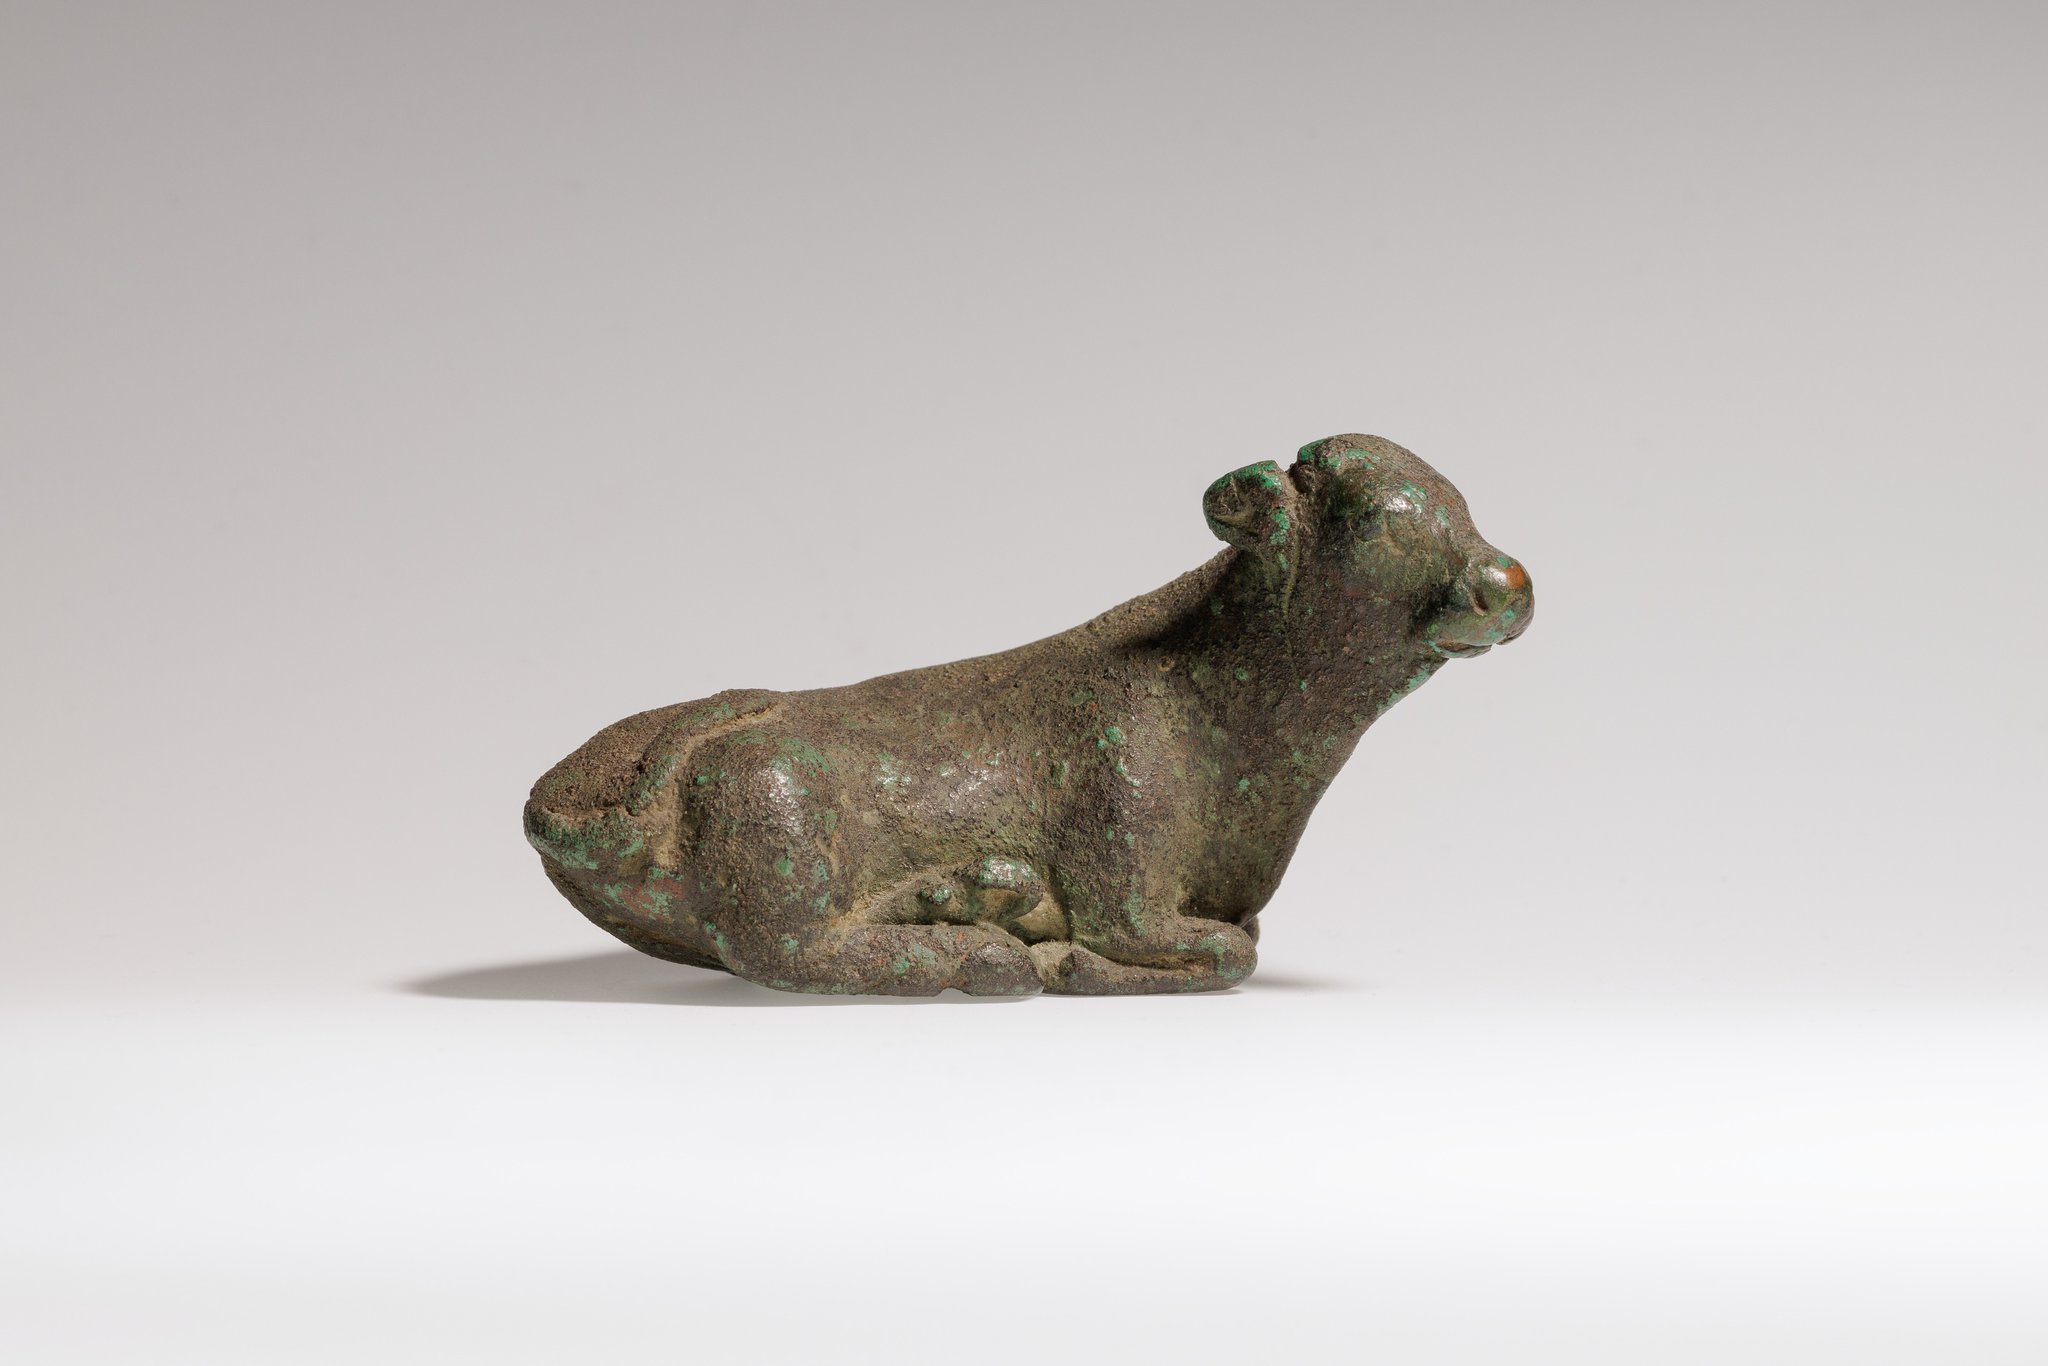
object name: weight, 6 deben, bull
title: Weight Weighing Six Deben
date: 1550-1295 BCE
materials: bronze, copper alloy, lead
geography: egypt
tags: animals